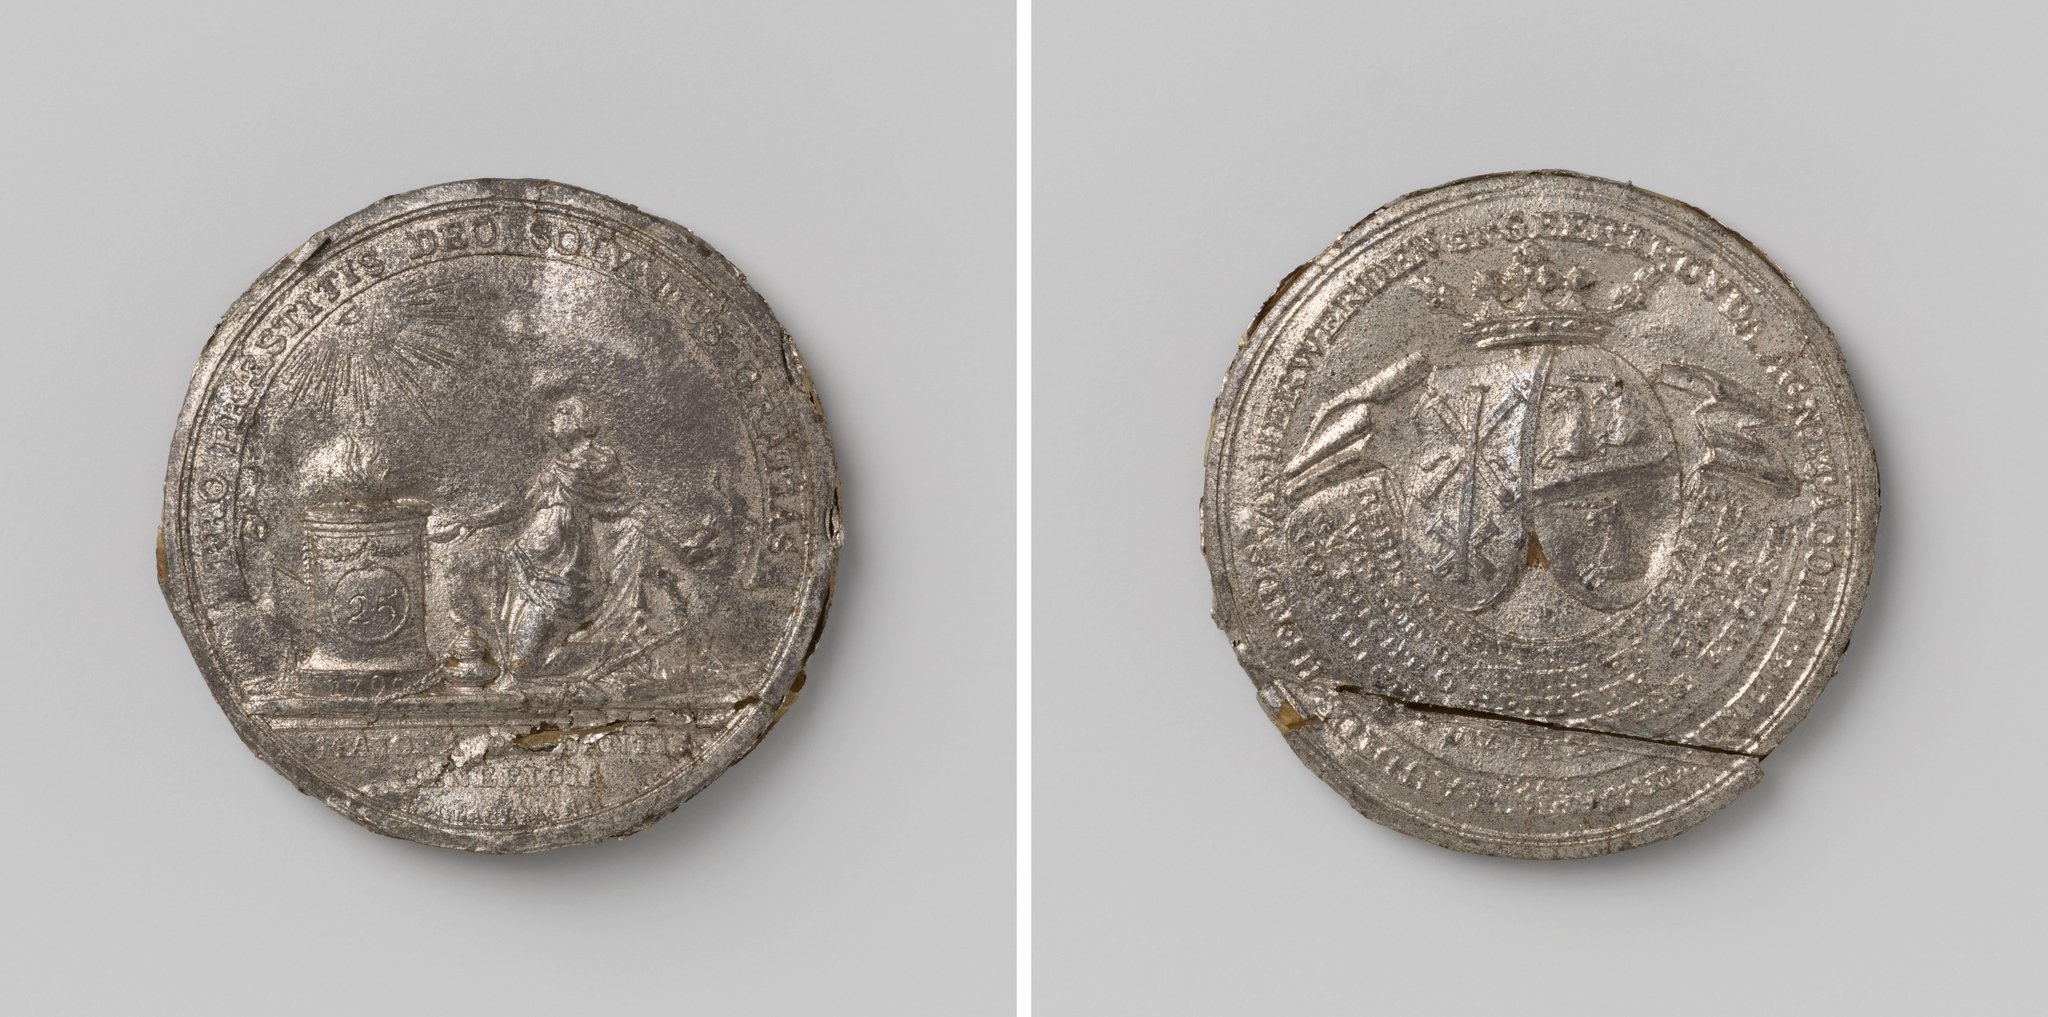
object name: huwelijksjubileumpenning 25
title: Vijfentwintigjarig huwelijk van Claudius Henricus van Herwerden en Geertruyda Agneta Commelin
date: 1790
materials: wax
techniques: casting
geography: amsterdam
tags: bad eilsen, predikant, claudius henricus van herwerden, geertruyda agneta commelin